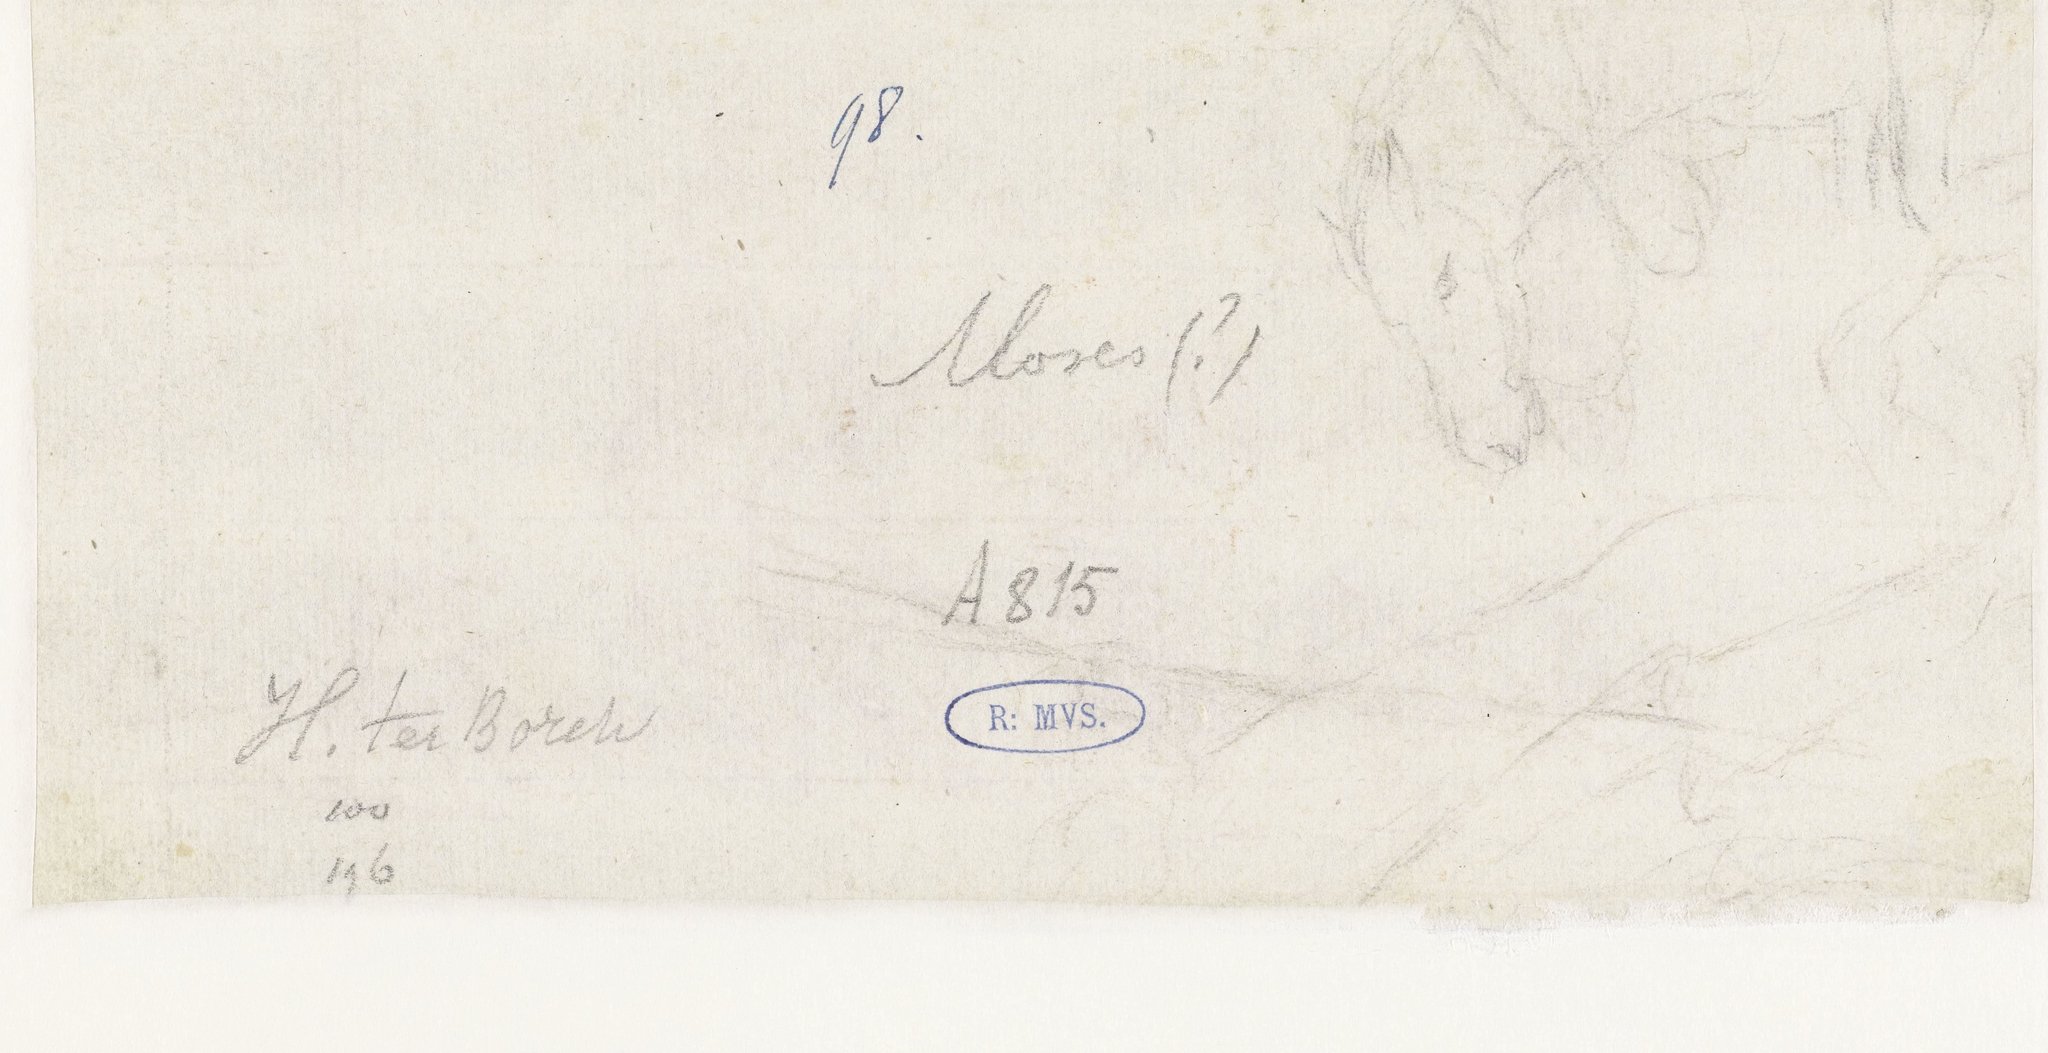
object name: drawing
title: Schets van een paard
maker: gesina ter borch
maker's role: draughtsman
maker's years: 1633-1690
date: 1660-1669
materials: chalk, paper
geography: zwolle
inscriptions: annotation: ‘H.ter Borch’